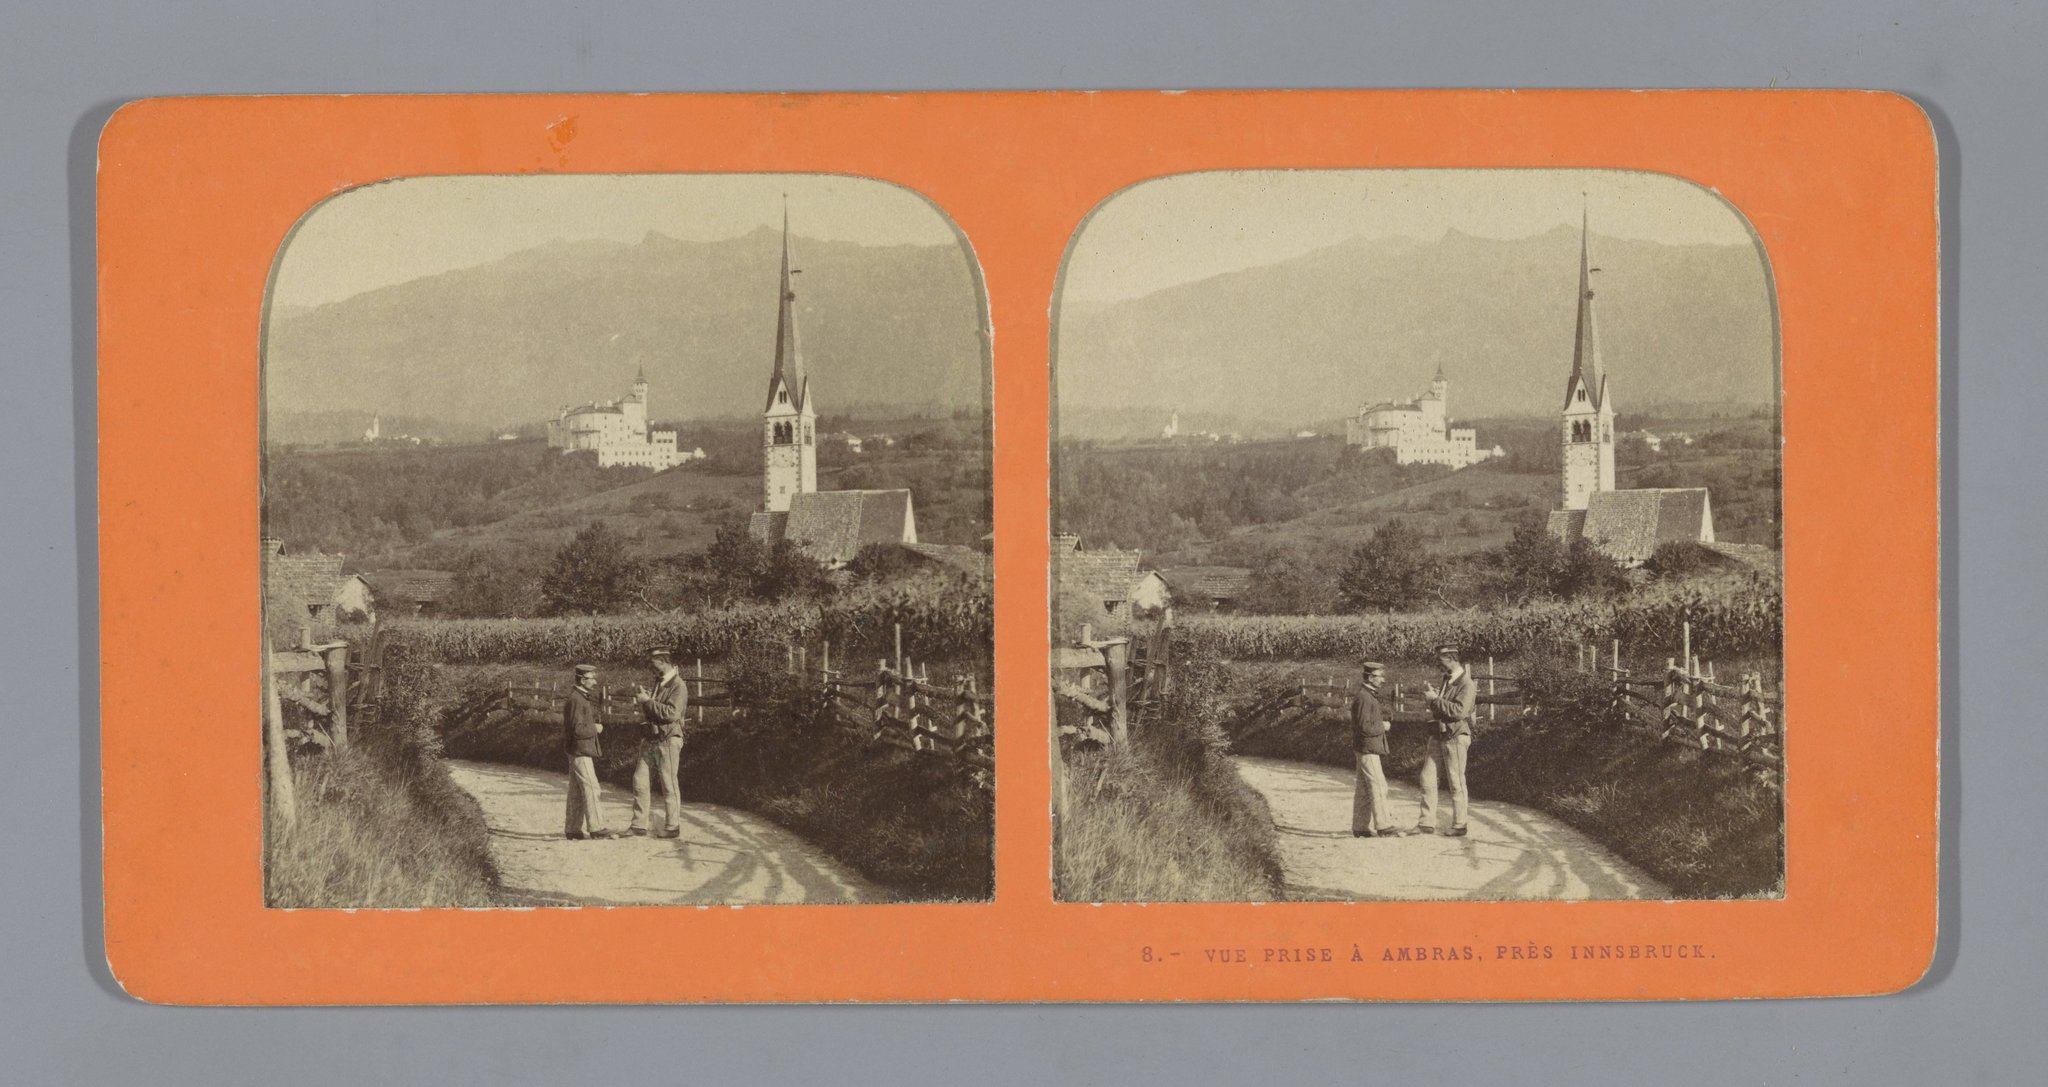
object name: tissue stereograph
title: Gezicht op Amras, Tirol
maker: Anonymous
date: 1855-1875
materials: cardboard, paper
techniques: albumen print, hand coloring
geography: amras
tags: church (exterior), landscape with tower or castle, mountains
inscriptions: number: ‘8.’, number: ‘15/ 67’